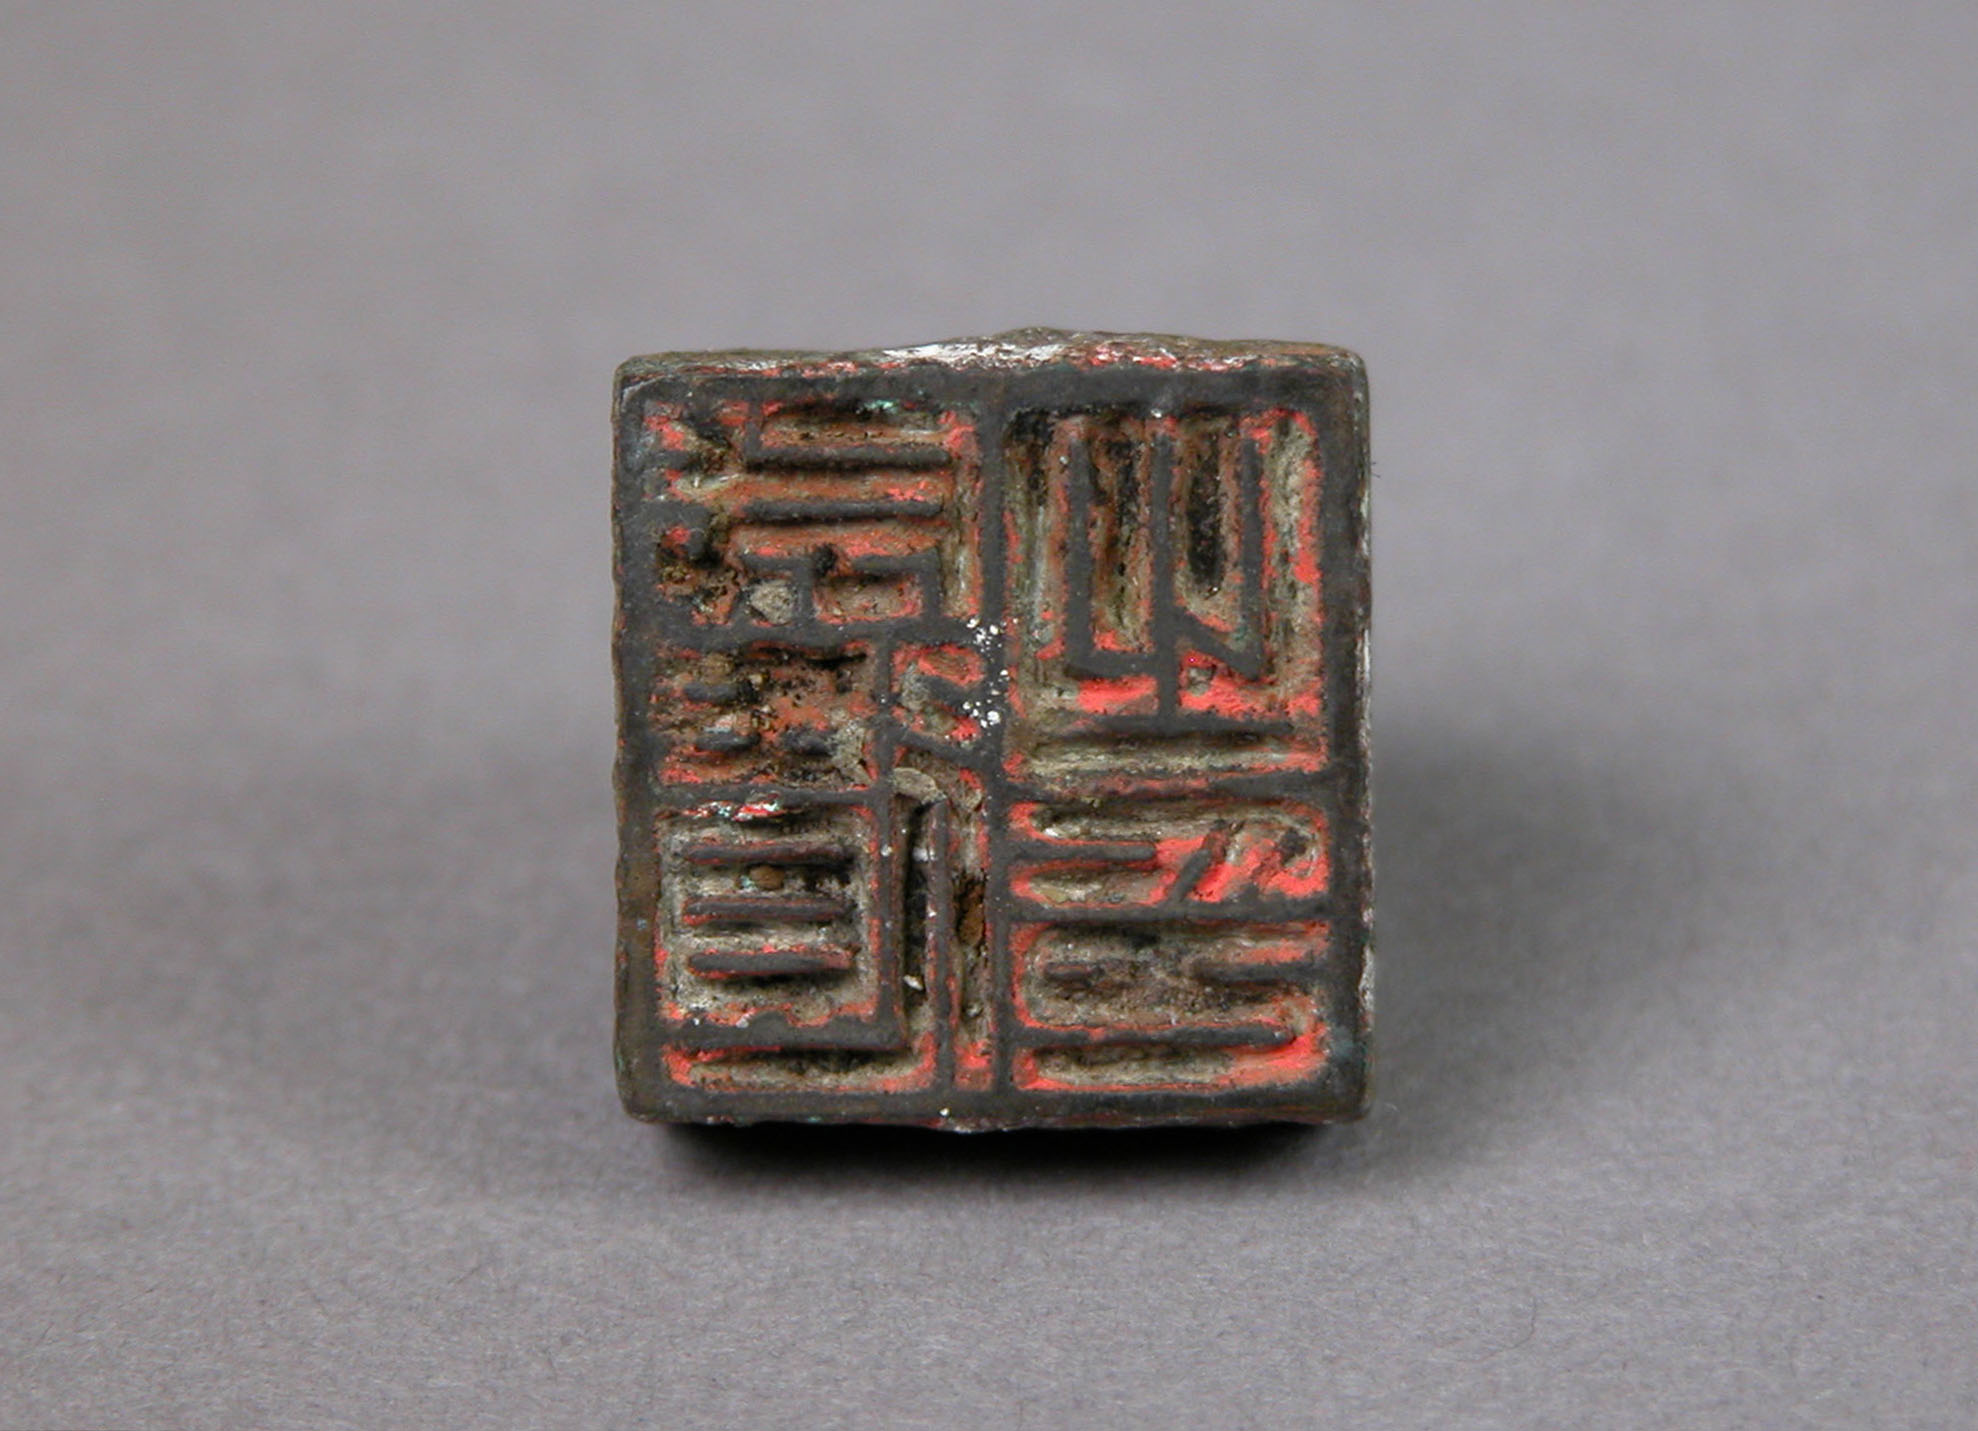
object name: seal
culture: chinese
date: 1368-1644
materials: bronze